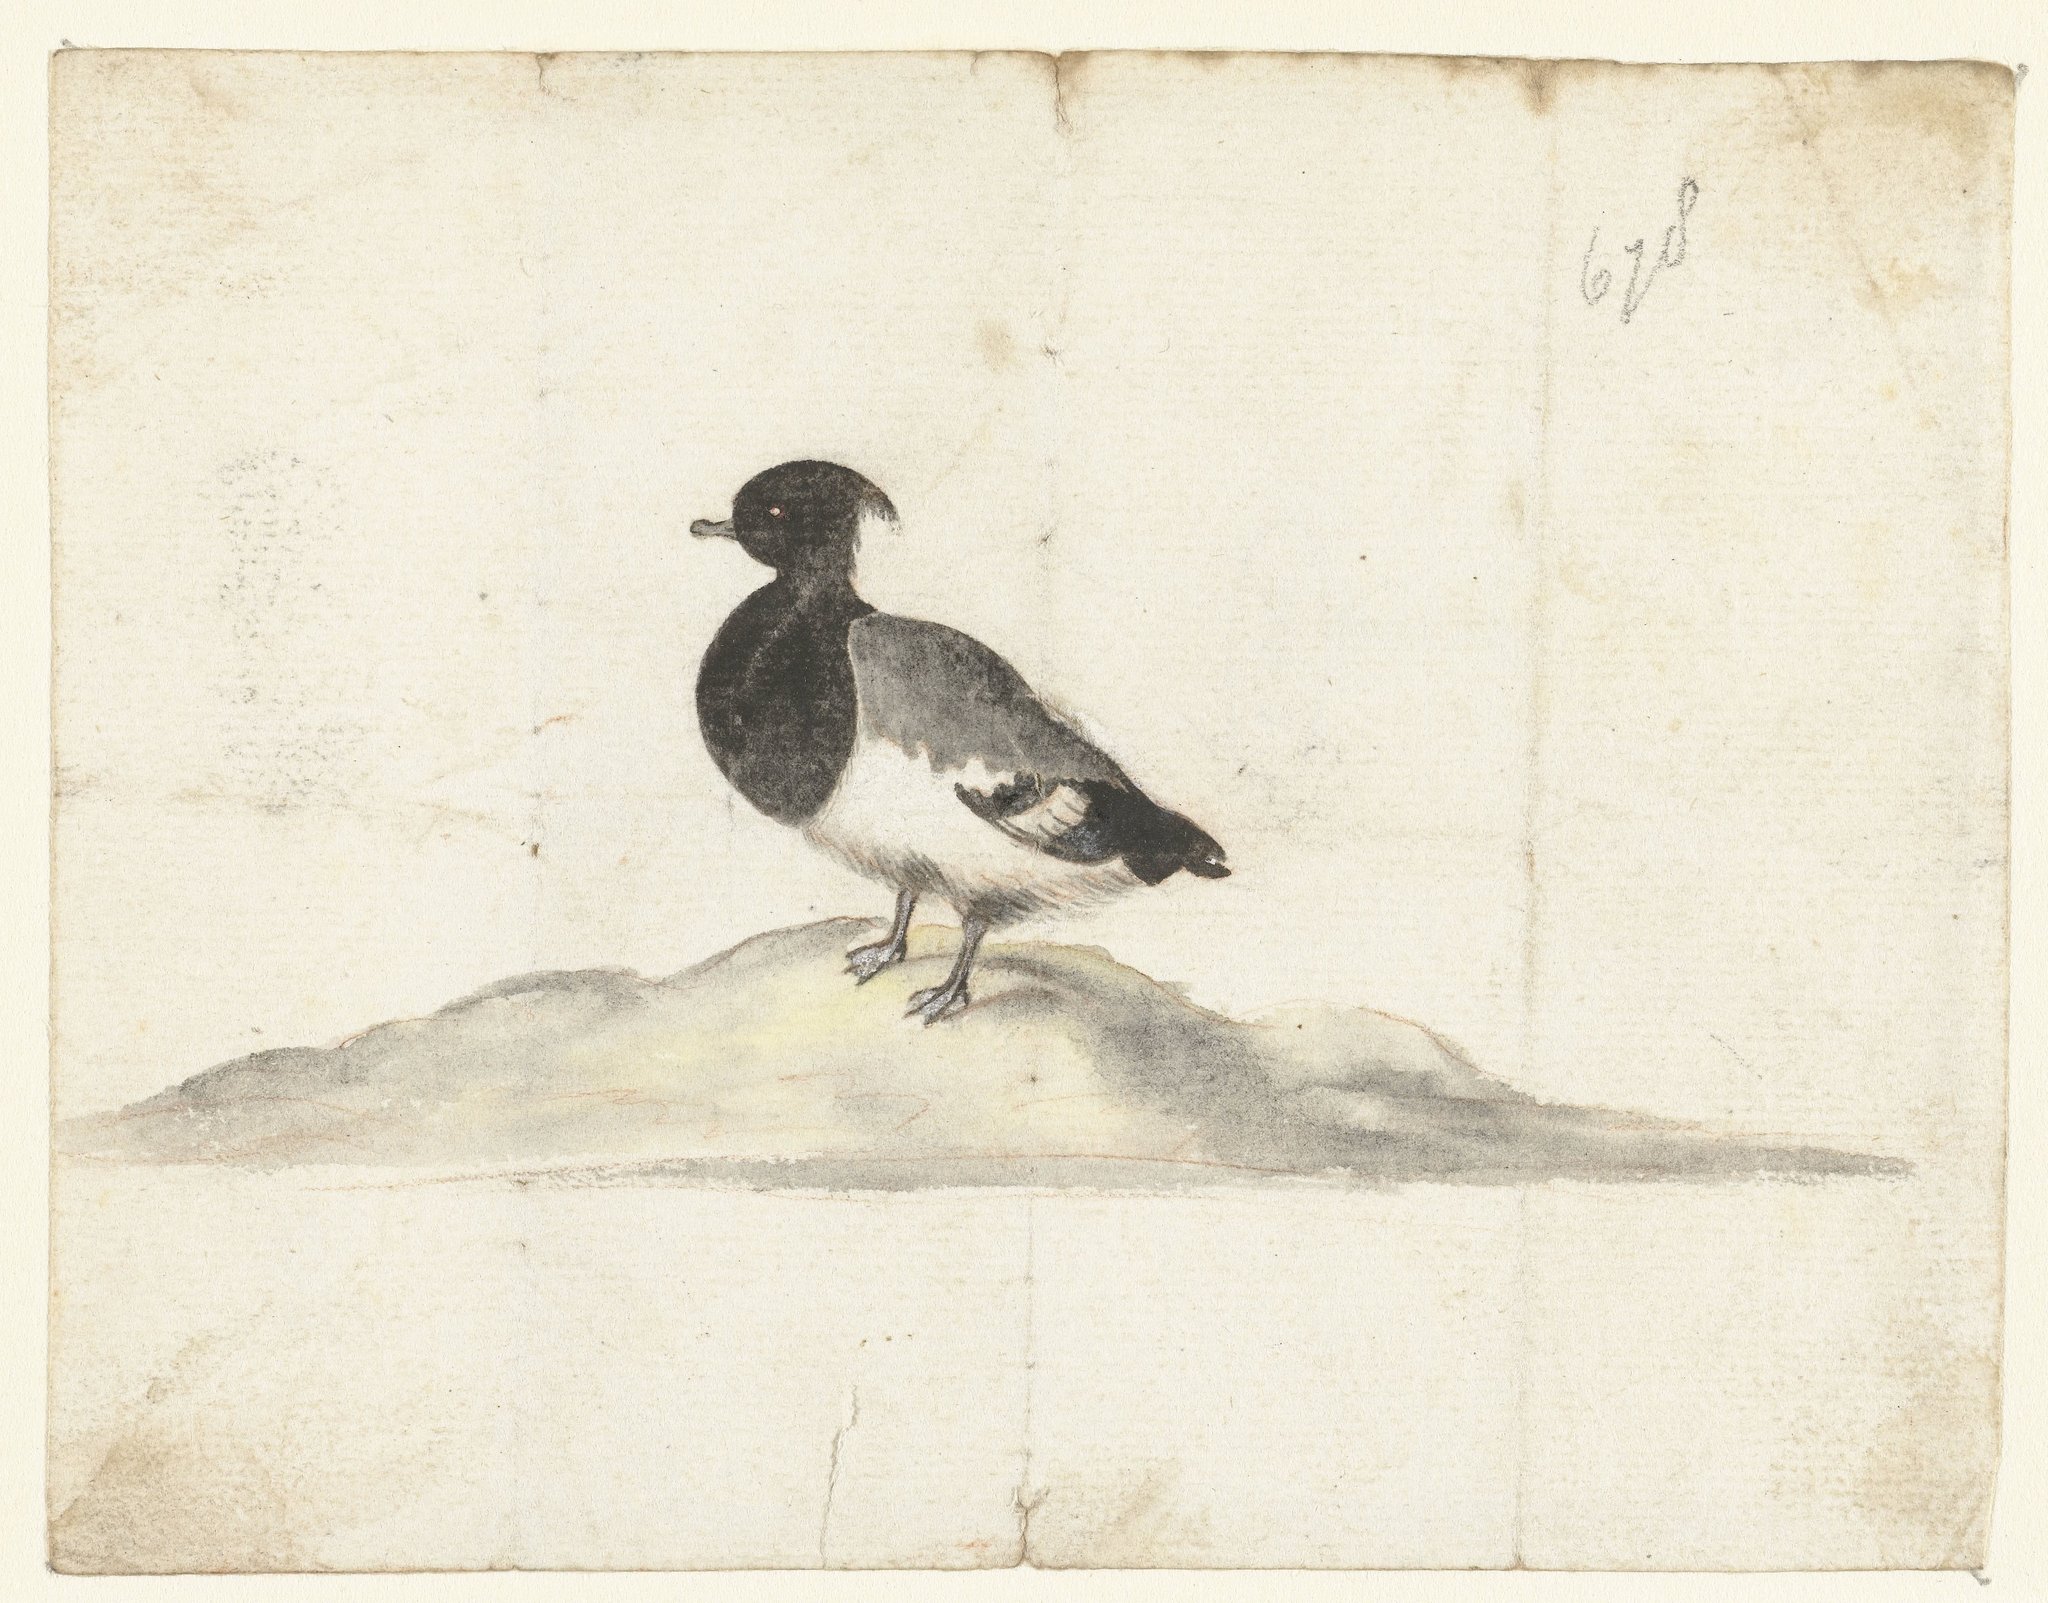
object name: drawing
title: Kuifeend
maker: anna cornelia moda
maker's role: draughtsman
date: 1600-1699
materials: chalk, paper, watercolor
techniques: brush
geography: zwolle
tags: water-birds: tufted duck